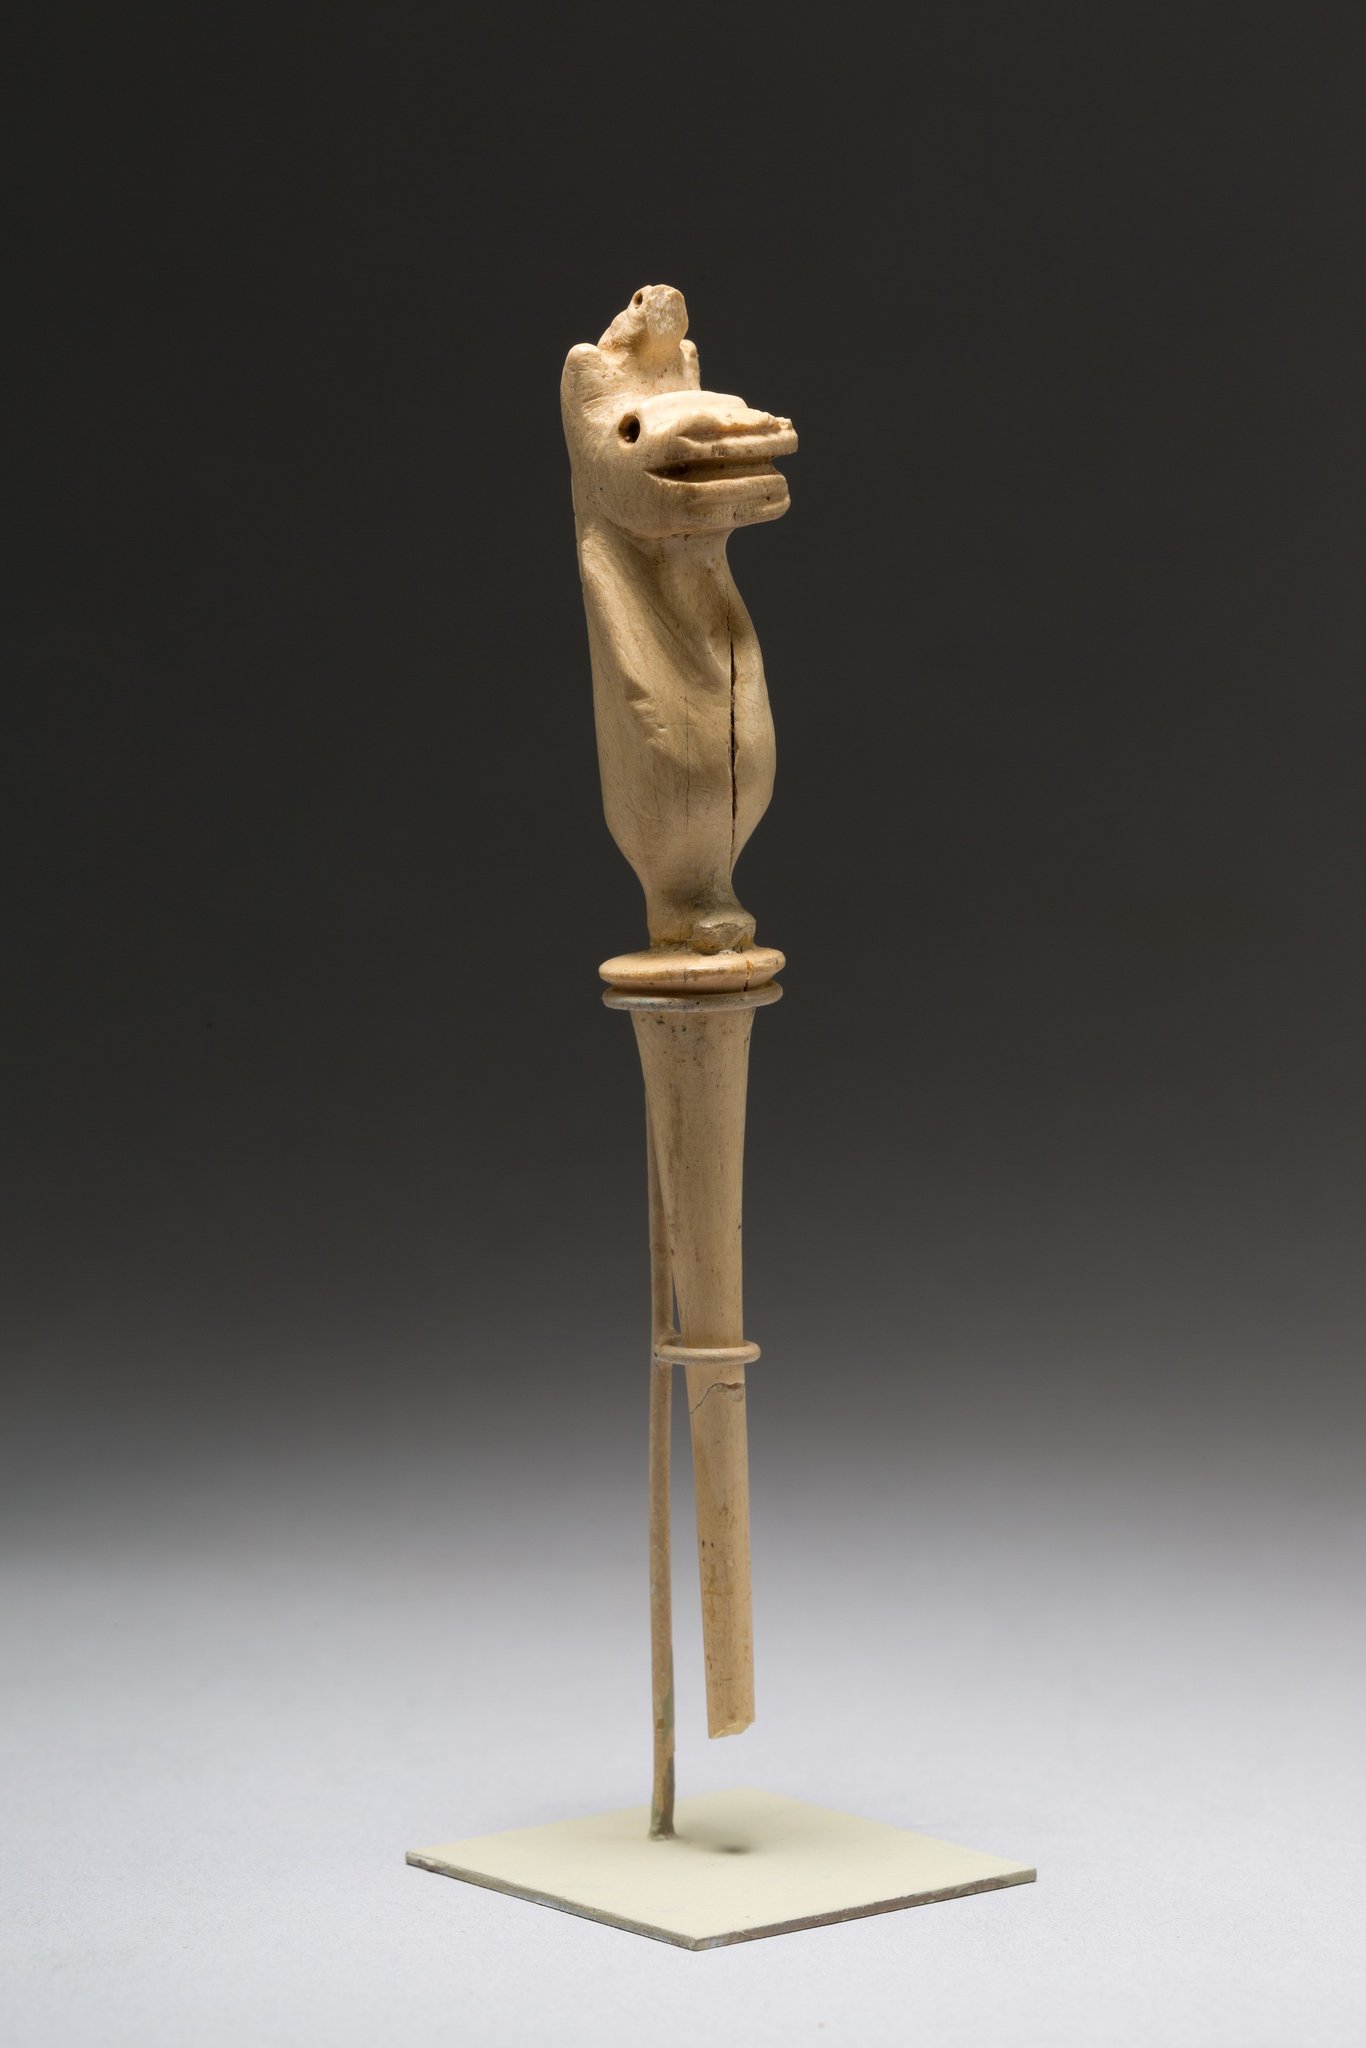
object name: hairpin, hippopotamus, taweret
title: Hairpin Decorated with a Hippopotamus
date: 1840-1640 BCE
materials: ivory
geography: egypt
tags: hippos